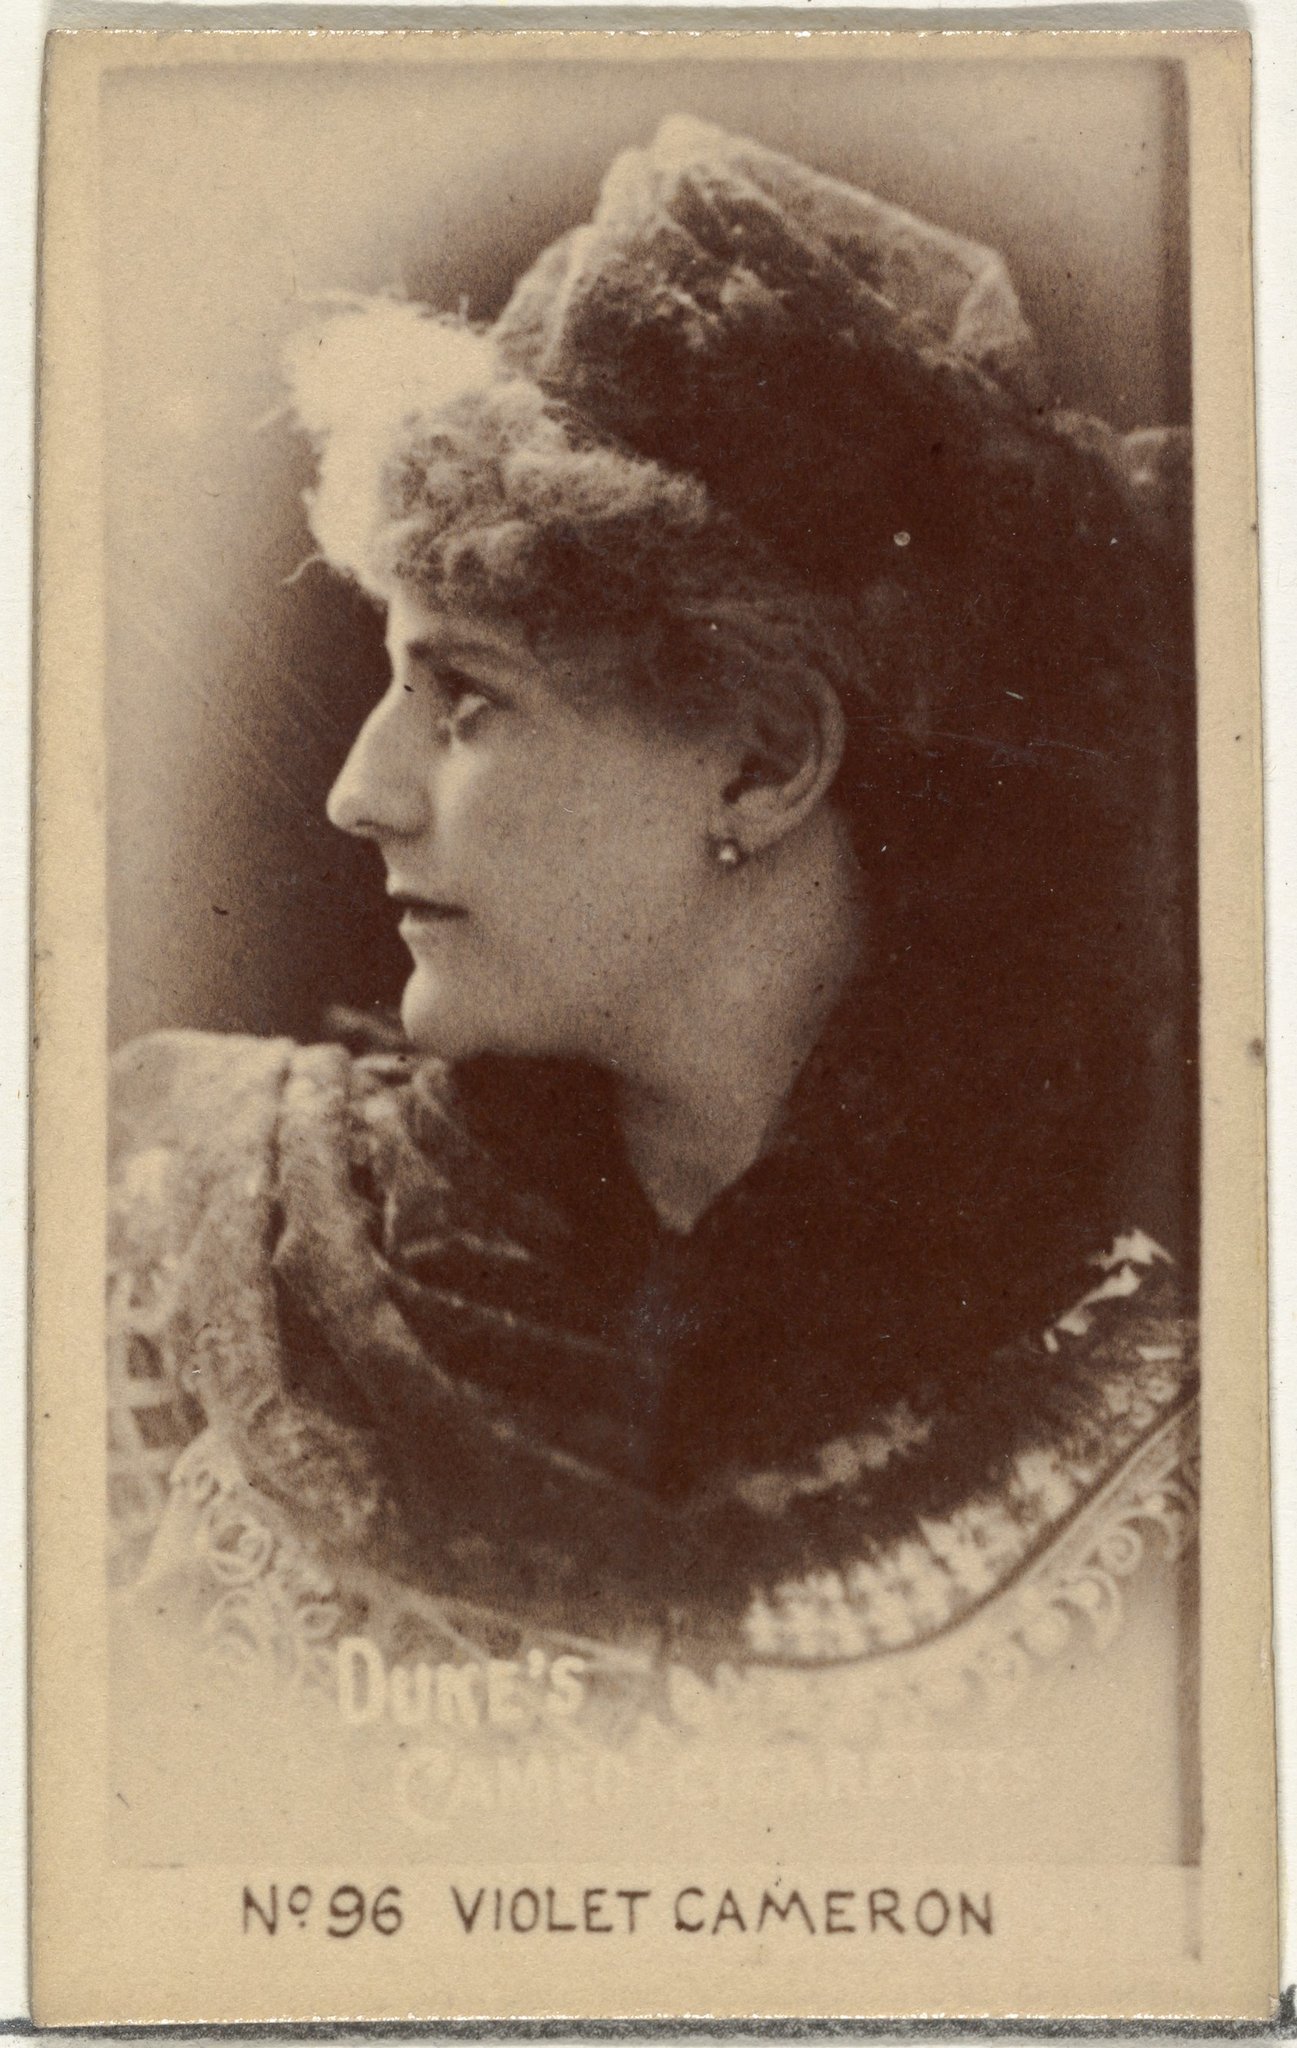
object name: photograph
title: Card Number 96, Violet Cameron, from the Actors and Actresses series (N145-4) issued by Duke Sons & Co. to promote Cameo Cigarettes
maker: w. duke, sons & co.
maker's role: publisher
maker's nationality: american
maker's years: 1870-1920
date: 1880-1889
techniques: albumen silver print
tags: women,actresses